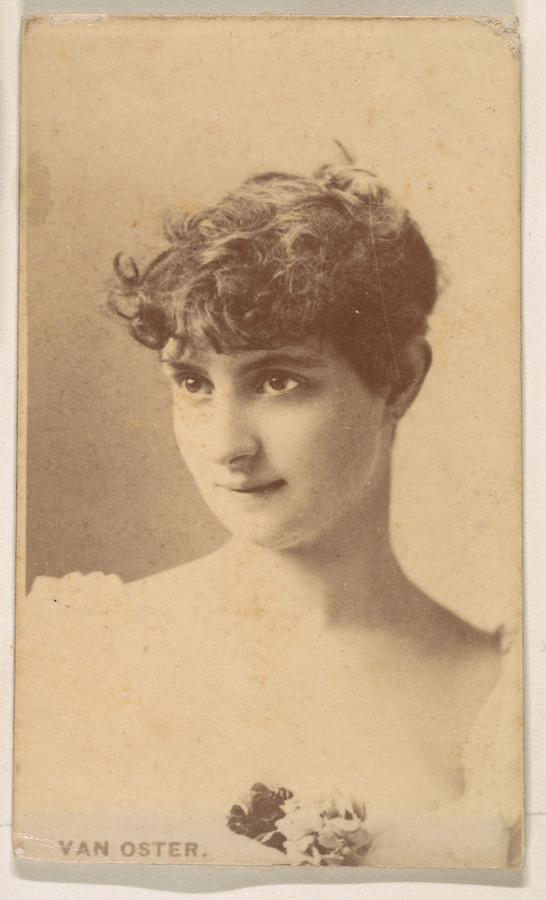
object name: photograph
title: Miss Van Oster, from the Actresses series (N246), Type 1, issued by Kinney Brothers to promote Sporting Extra Cigarettes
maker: kinney brothers tobacco company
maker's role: publisher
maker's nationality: american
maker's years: 1869-2011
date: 1890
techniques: albumen silver print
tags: portraits,women,actresses